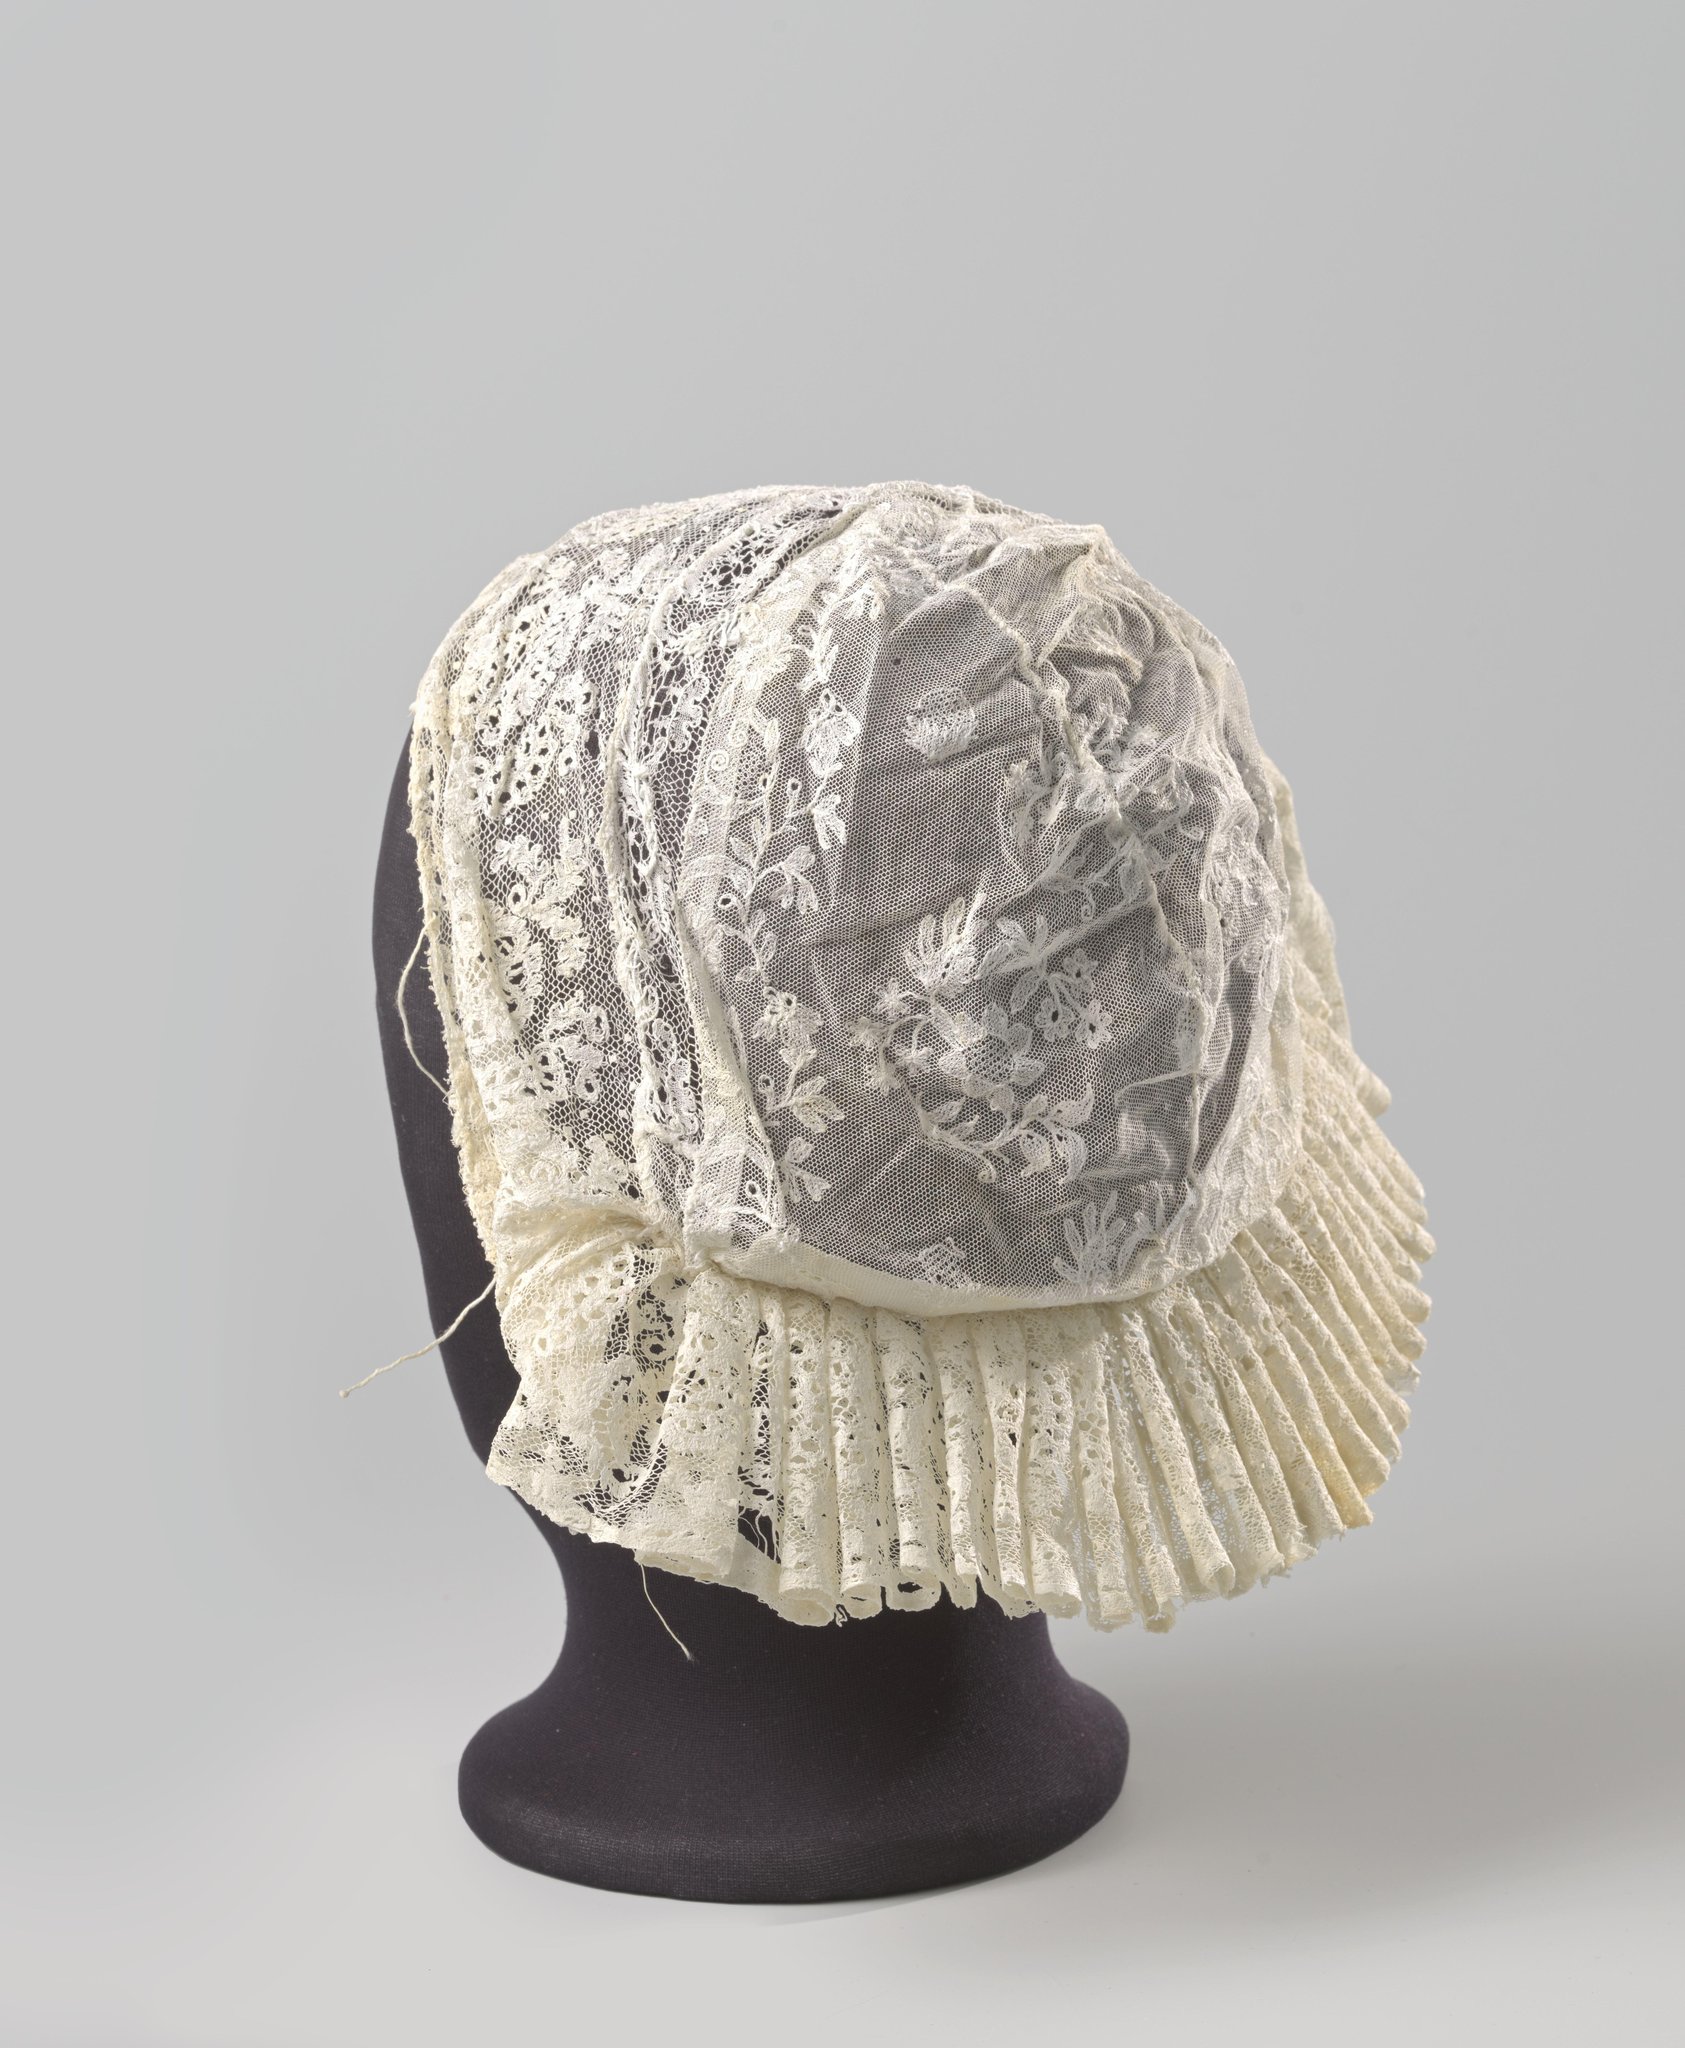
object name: cap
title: Muts met een bol van met doorstopwerk versierde tule, afgezet met een strook Rijsselse kant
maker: Anonymous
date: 1800-1900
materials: linen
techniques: lace, material, weave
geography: lille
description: Muts met een bol van met doorstopwerk versierde tule, afgezet met een strook Rijsselse kant, dat langs het voorhoofd is geplooid.